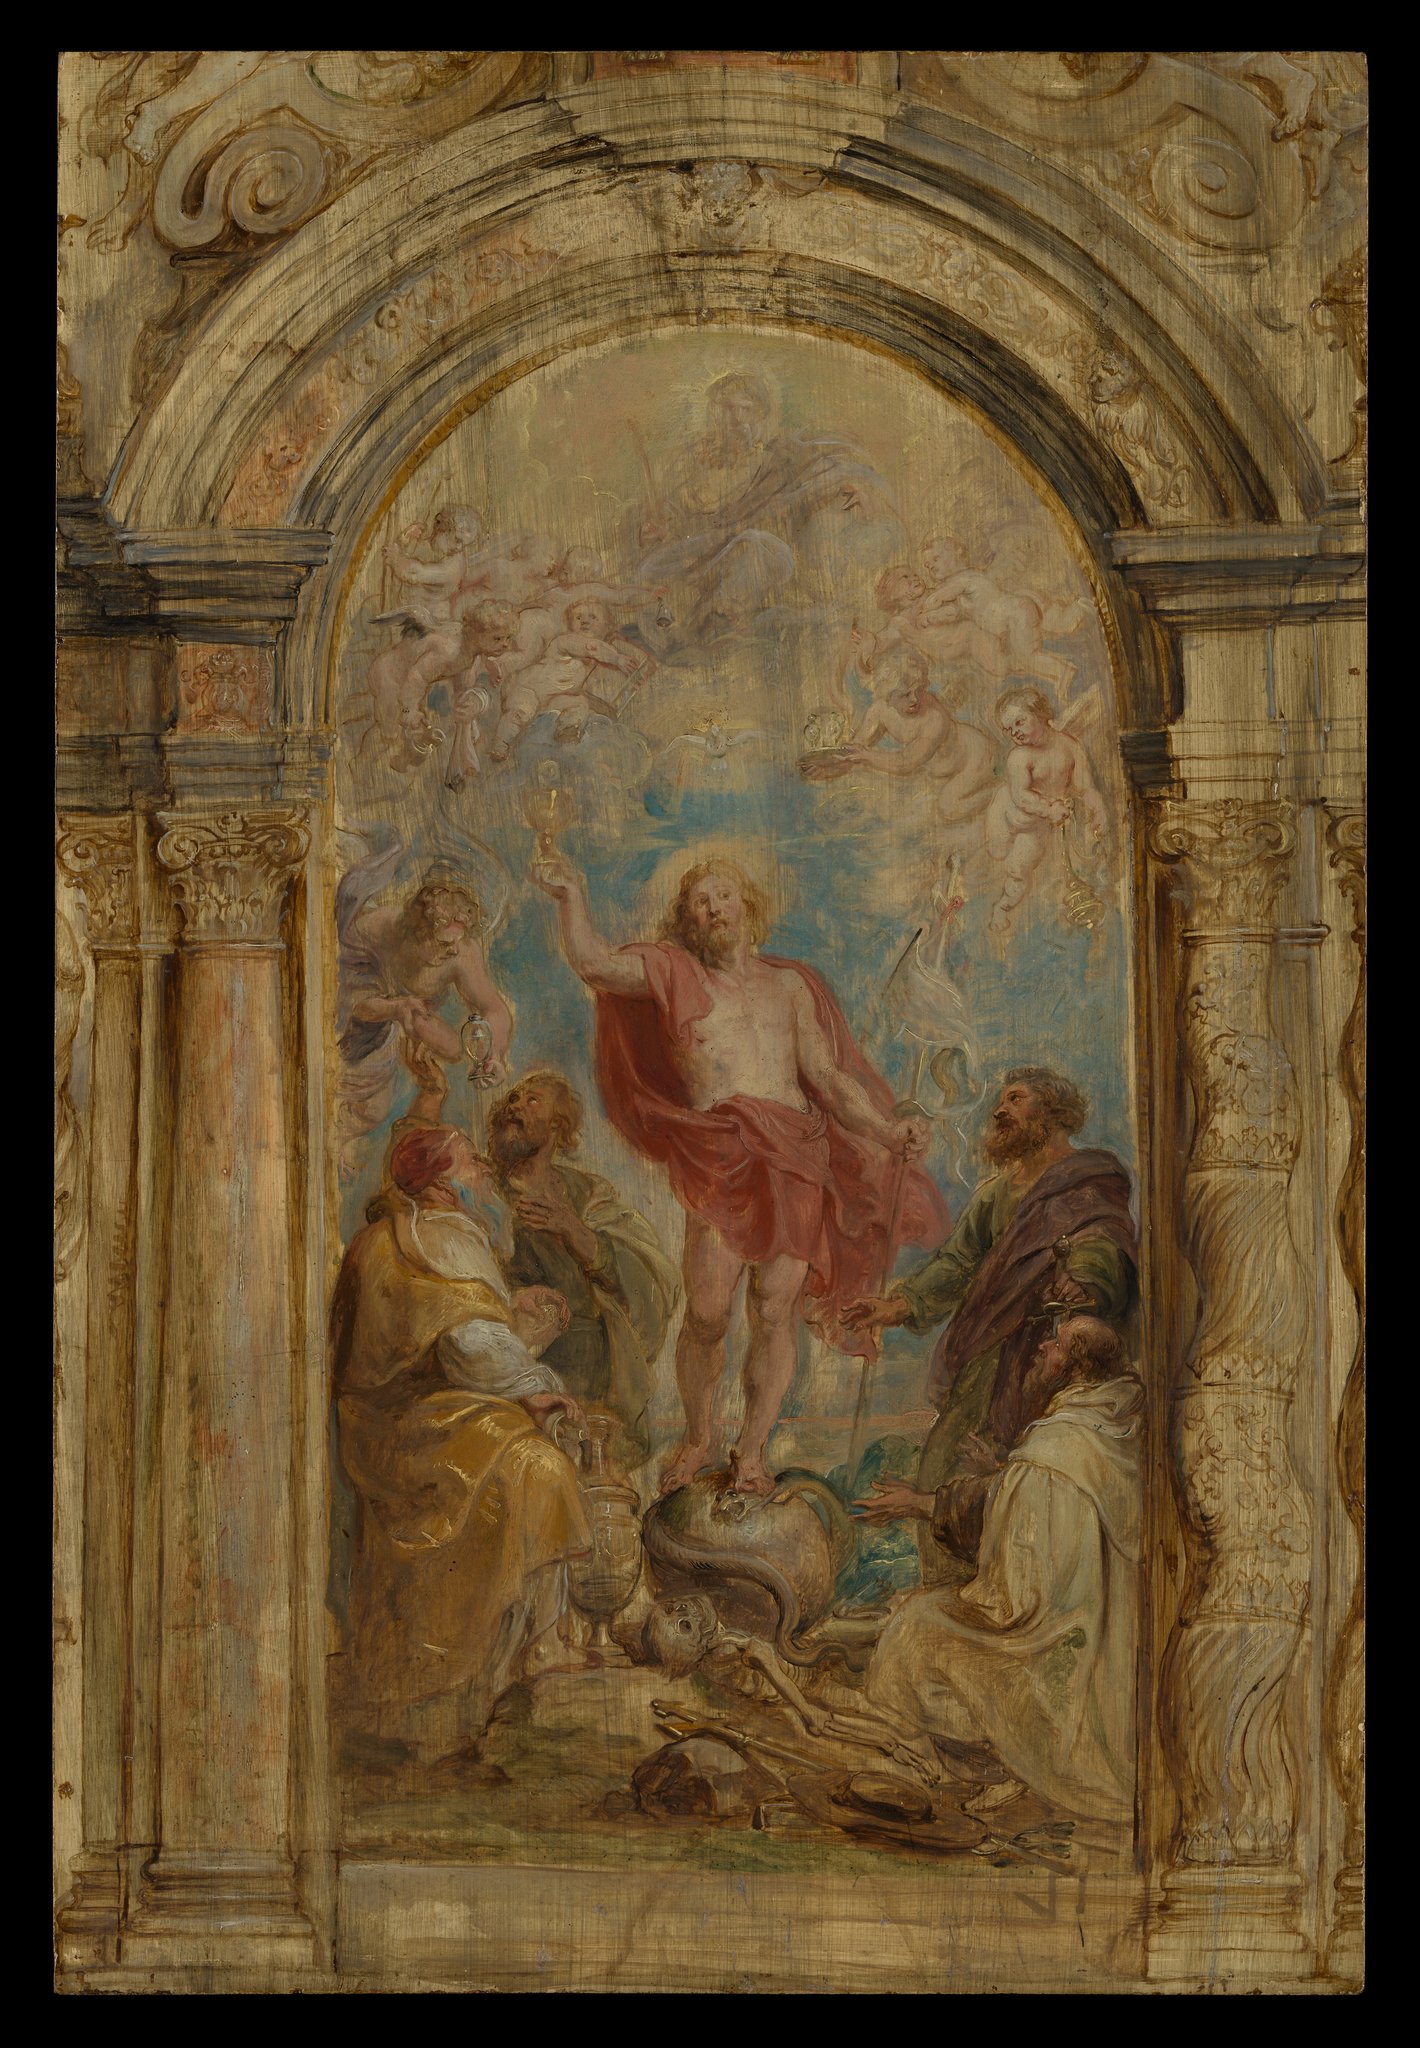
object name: painting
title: The Glorification of the Eucharist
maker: peter paul rubens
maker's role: artist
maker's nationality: flemish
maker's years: 1577-1640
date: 1630-1632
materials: oil, wood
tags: skeletons,snakes,angels,christ,saint paul